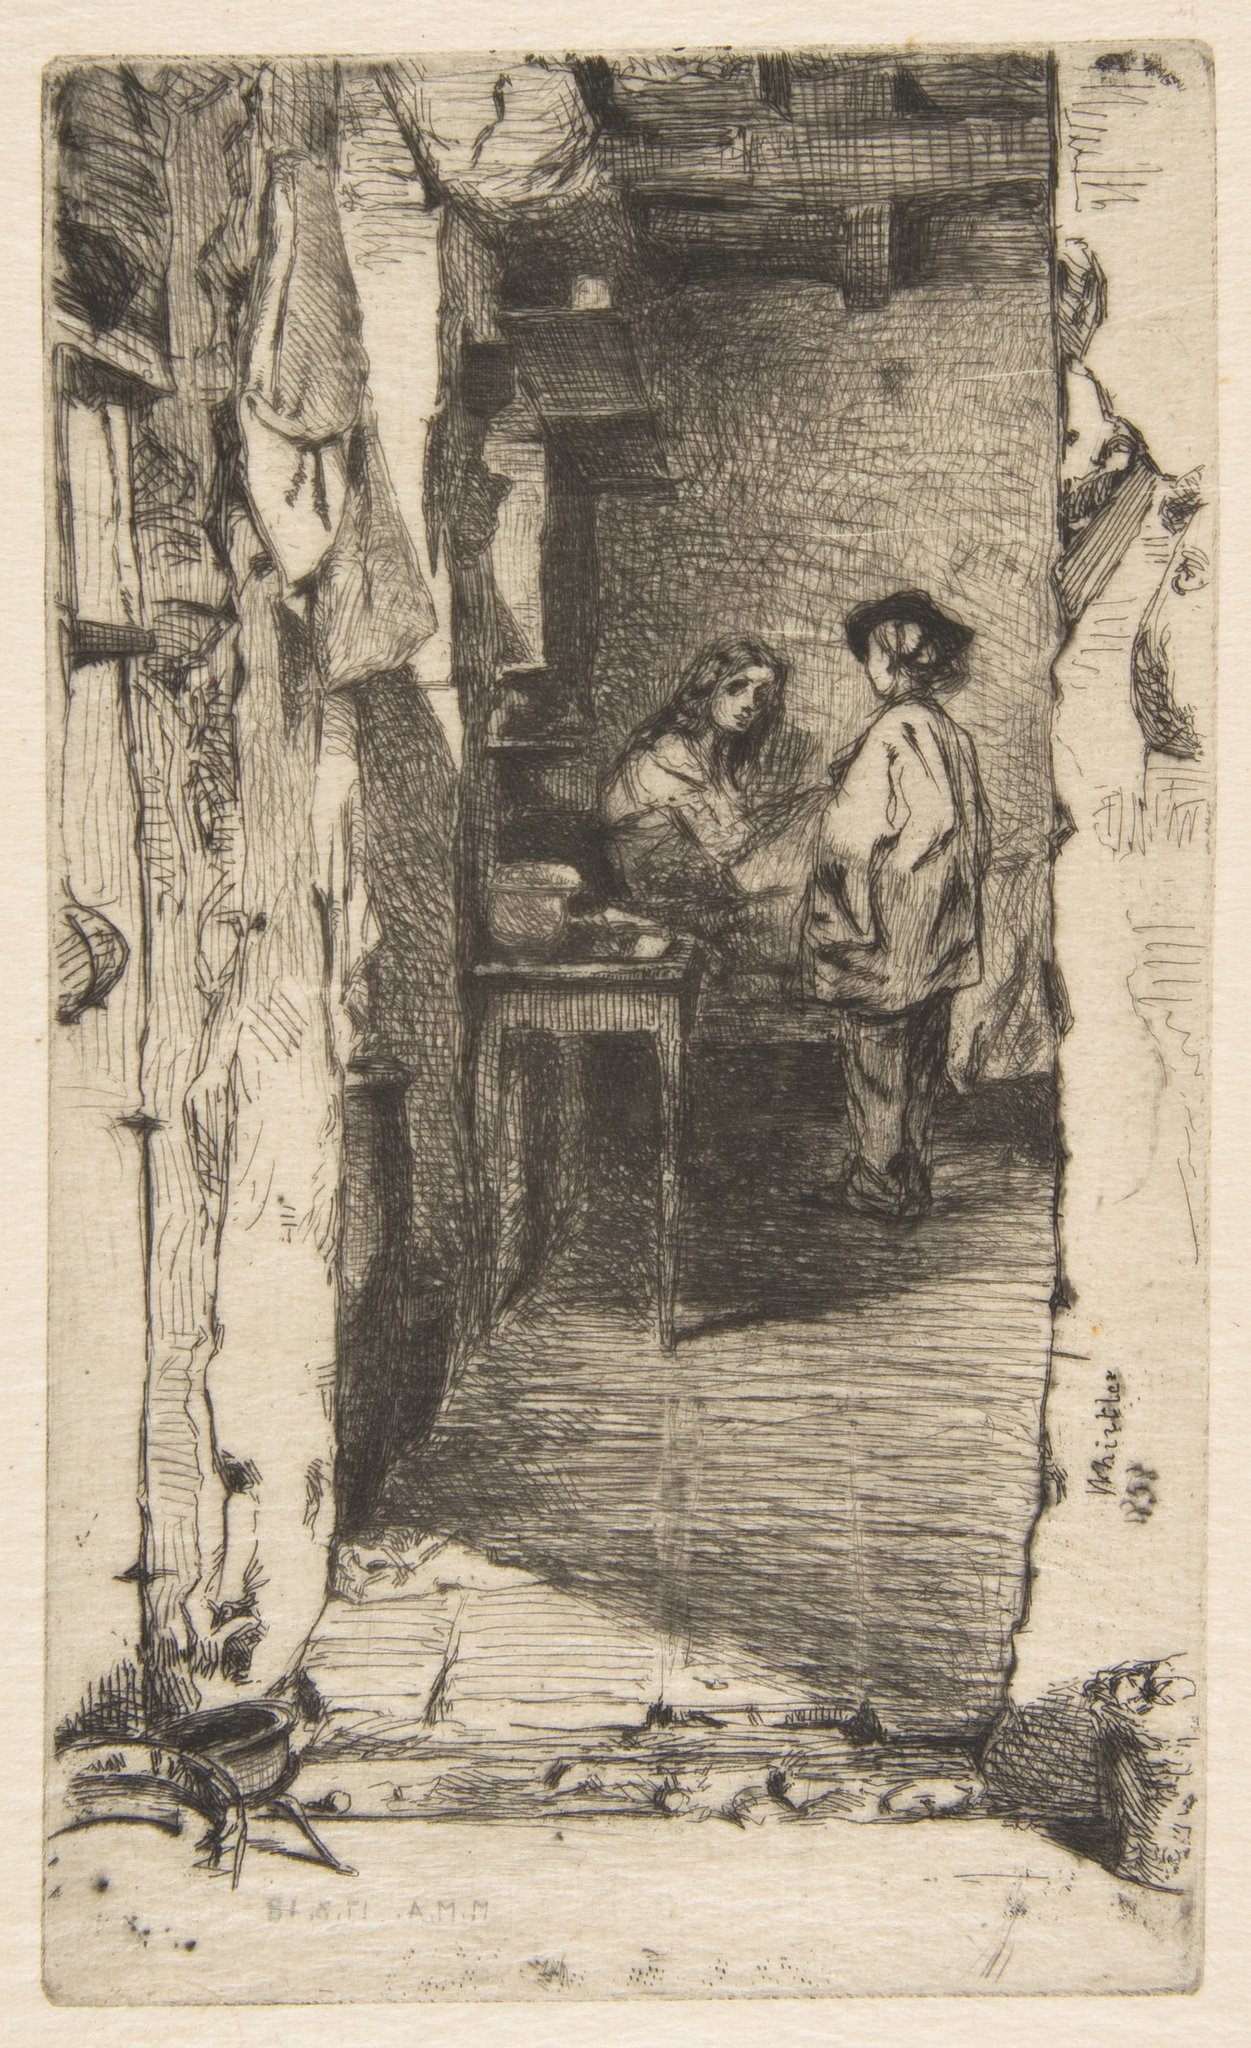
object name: print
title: The Rag Gatherers (Rag Pickers, Quartier Mouffetard, Paris)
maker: james mcneill whistler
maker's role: artist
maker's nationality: american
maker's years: 1834-1903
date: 1858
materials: ink, paper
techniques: drypoint, etching, printing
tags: boys,women